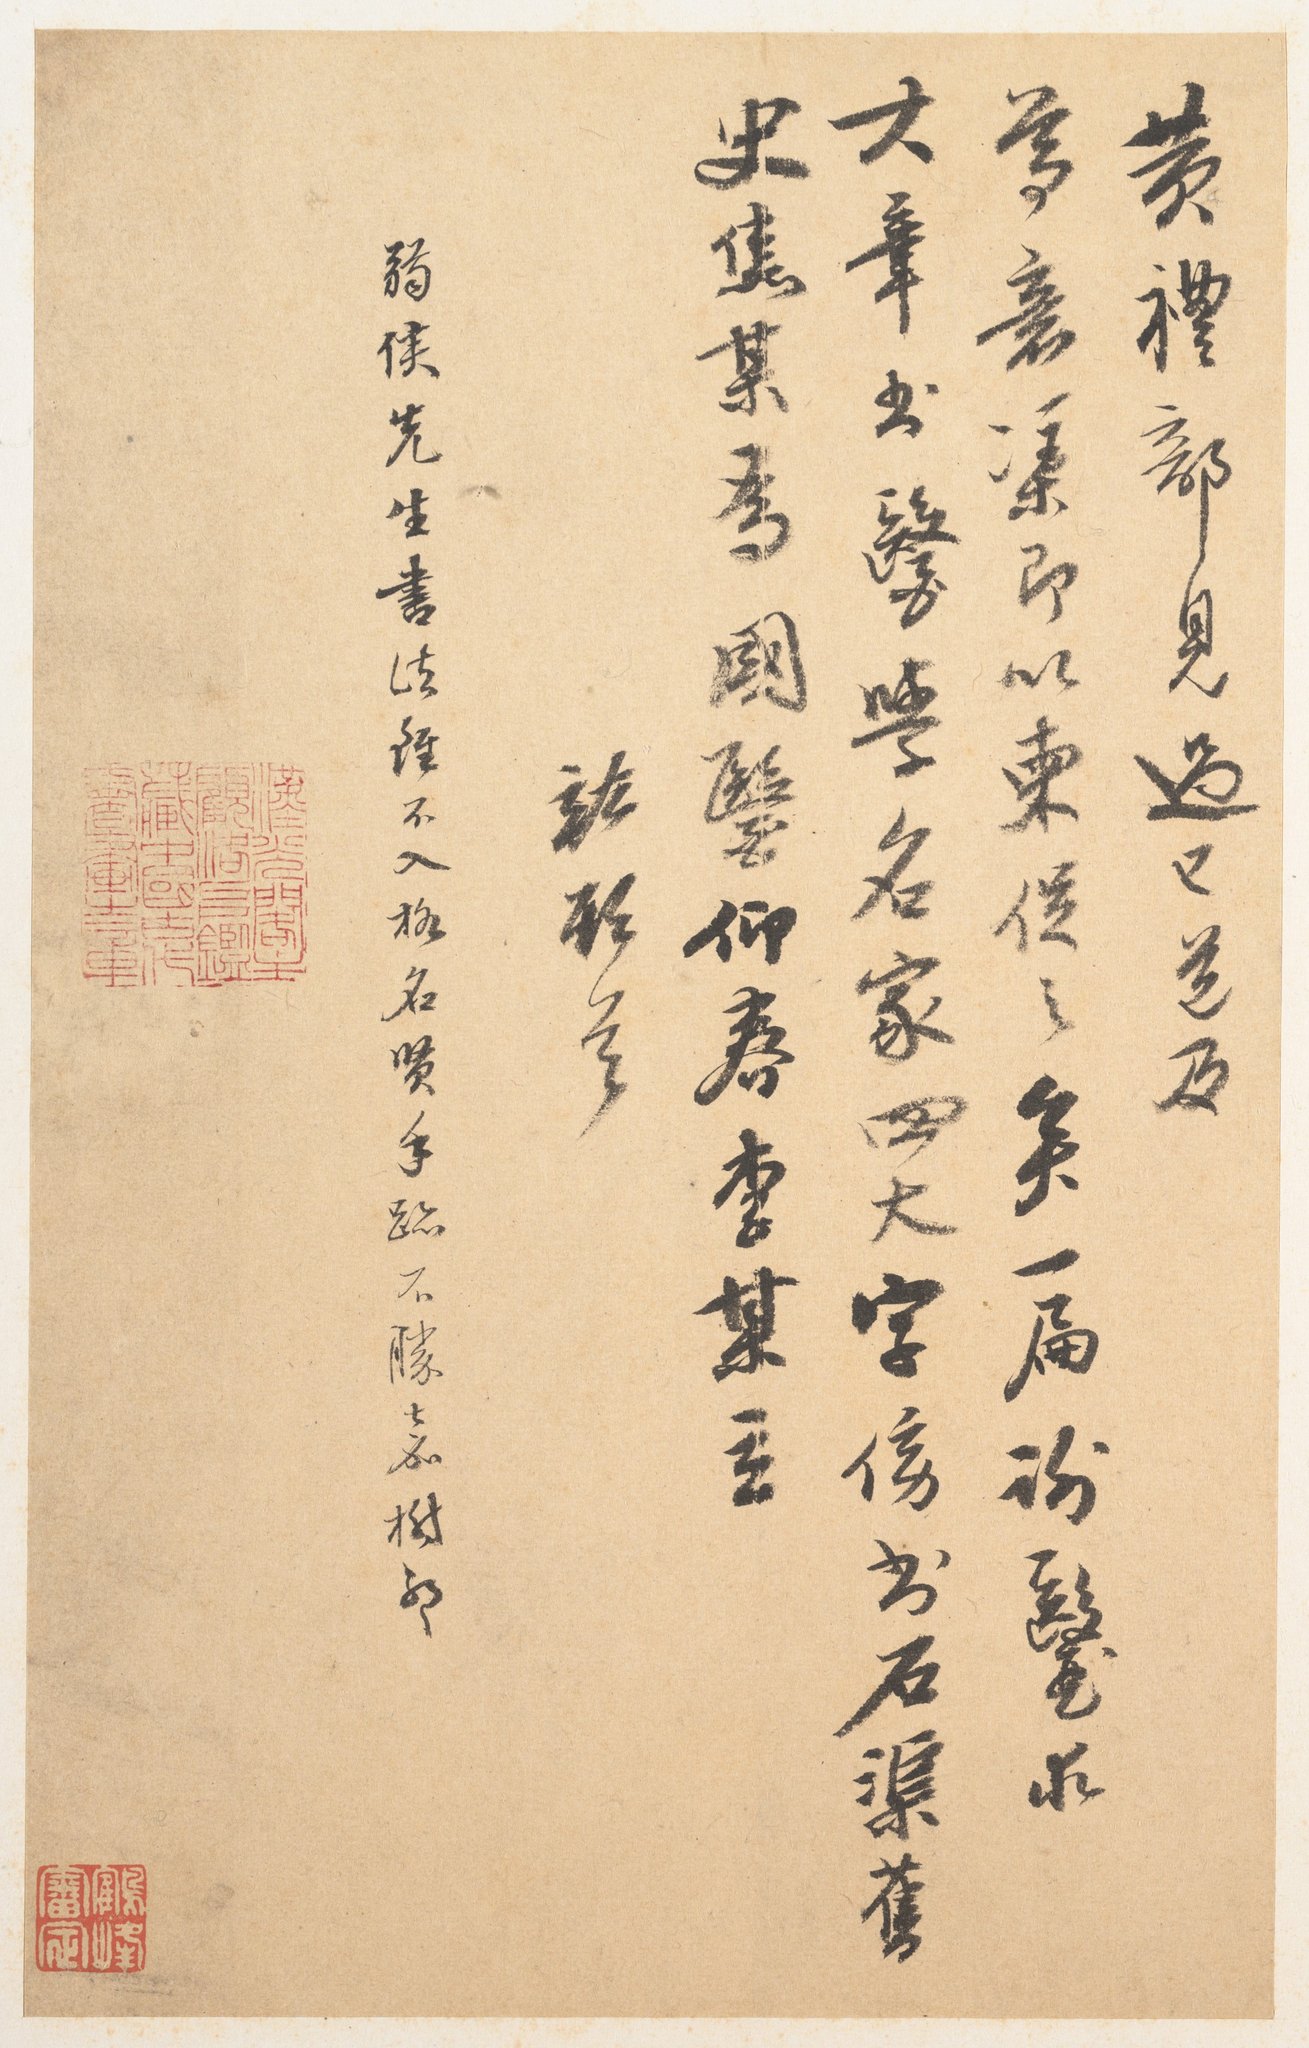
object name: album leaf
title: Letter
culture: chinese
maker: jiao hong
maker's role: artist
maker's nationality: chinese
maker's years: 1541-1620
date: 1541-1620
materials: ink, paper